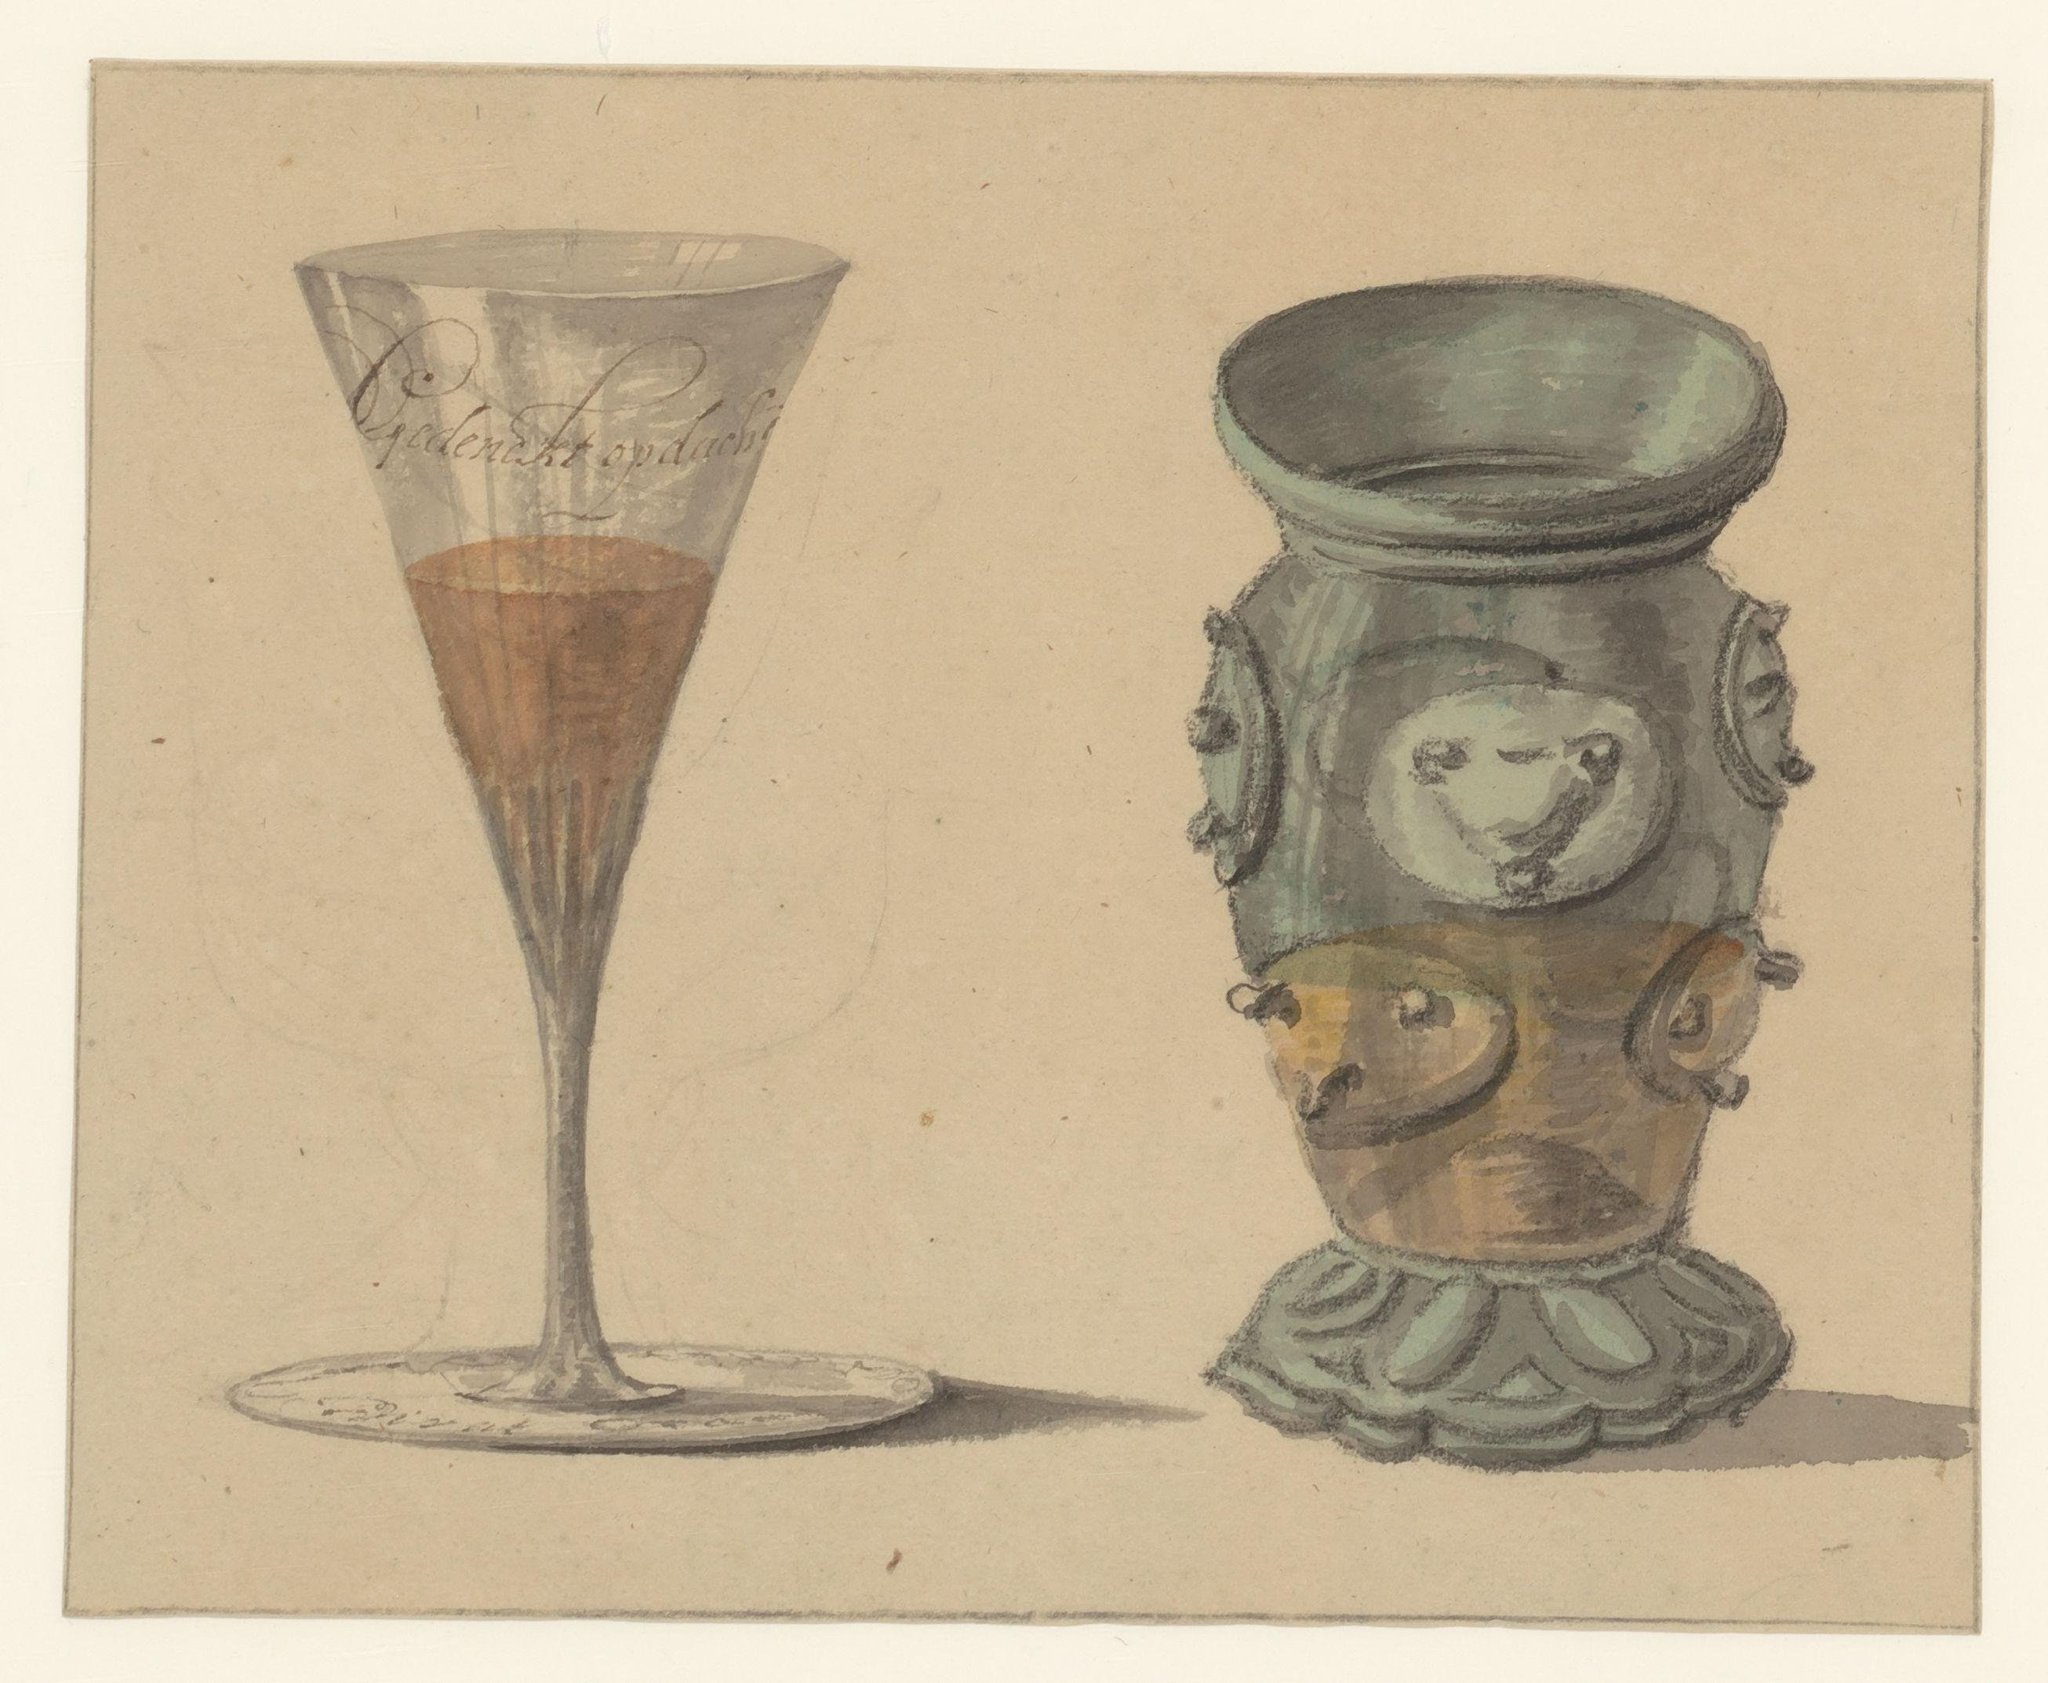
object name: drawing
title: Twee wijnglazen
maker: gerrit lamberts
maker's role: bookseller, draughtsman, print maker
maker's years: 1776-1850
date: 1790-1850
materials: chalk, ink, paper, pencil, watercolor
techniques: brush, pen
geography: netherlands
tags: glass, rummer, alcoholic drinks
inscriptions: collector's mark, collector's mark: Lugt 1641